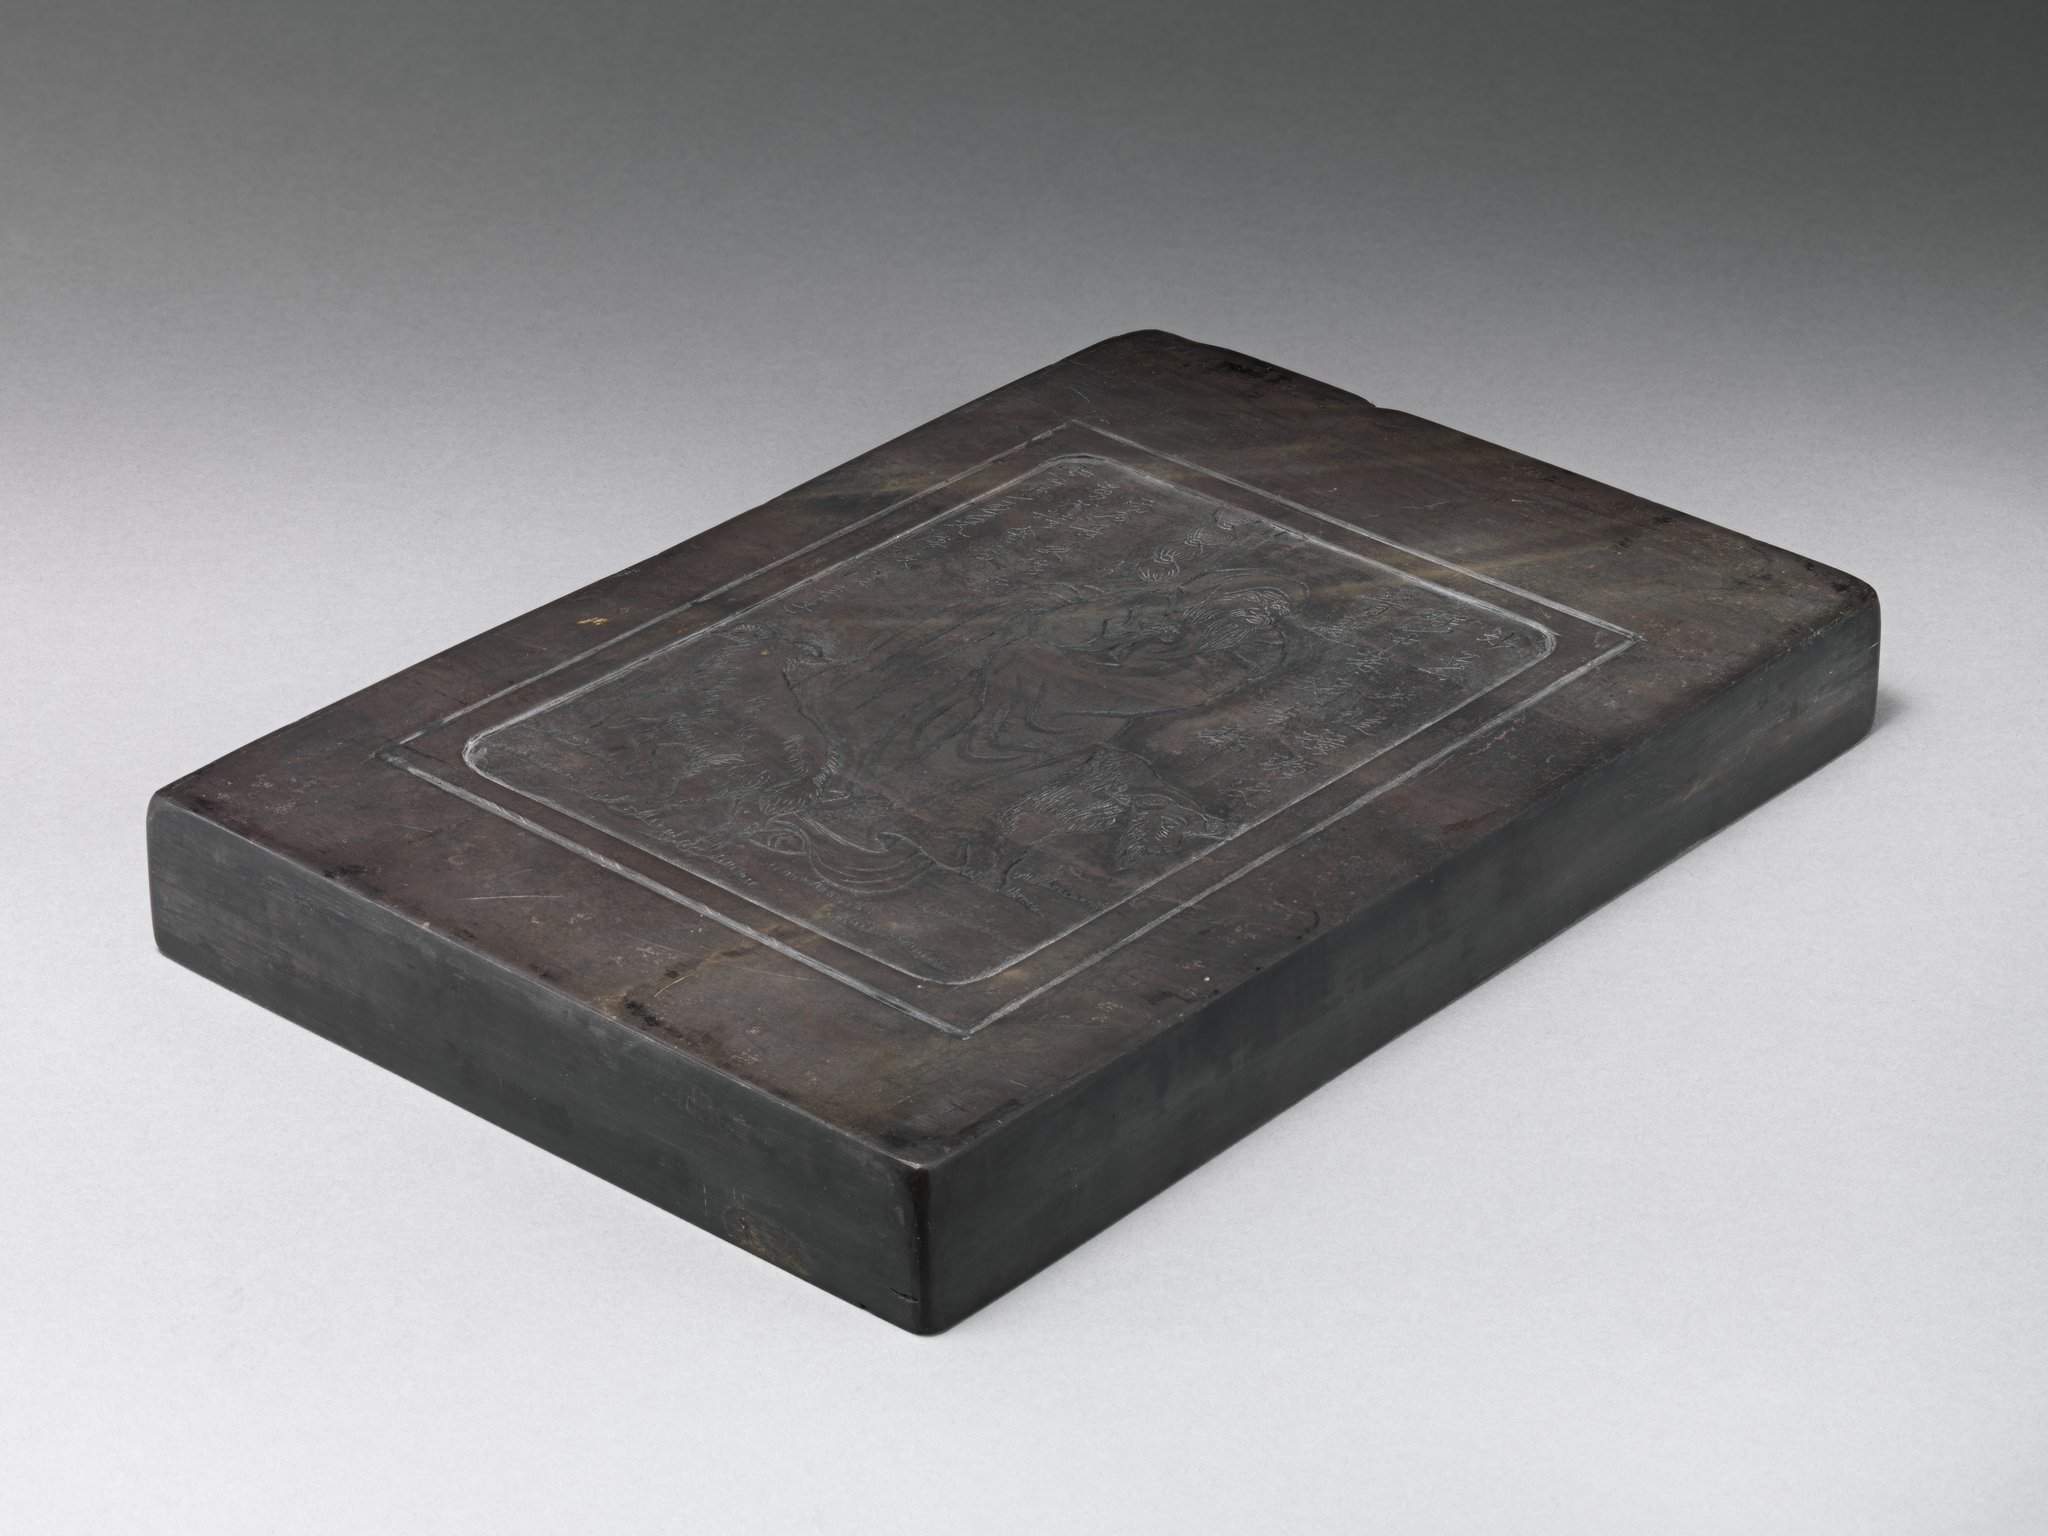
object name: inkstone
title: Inkstone with Su Wu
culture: chinese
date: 1701-1900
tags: men